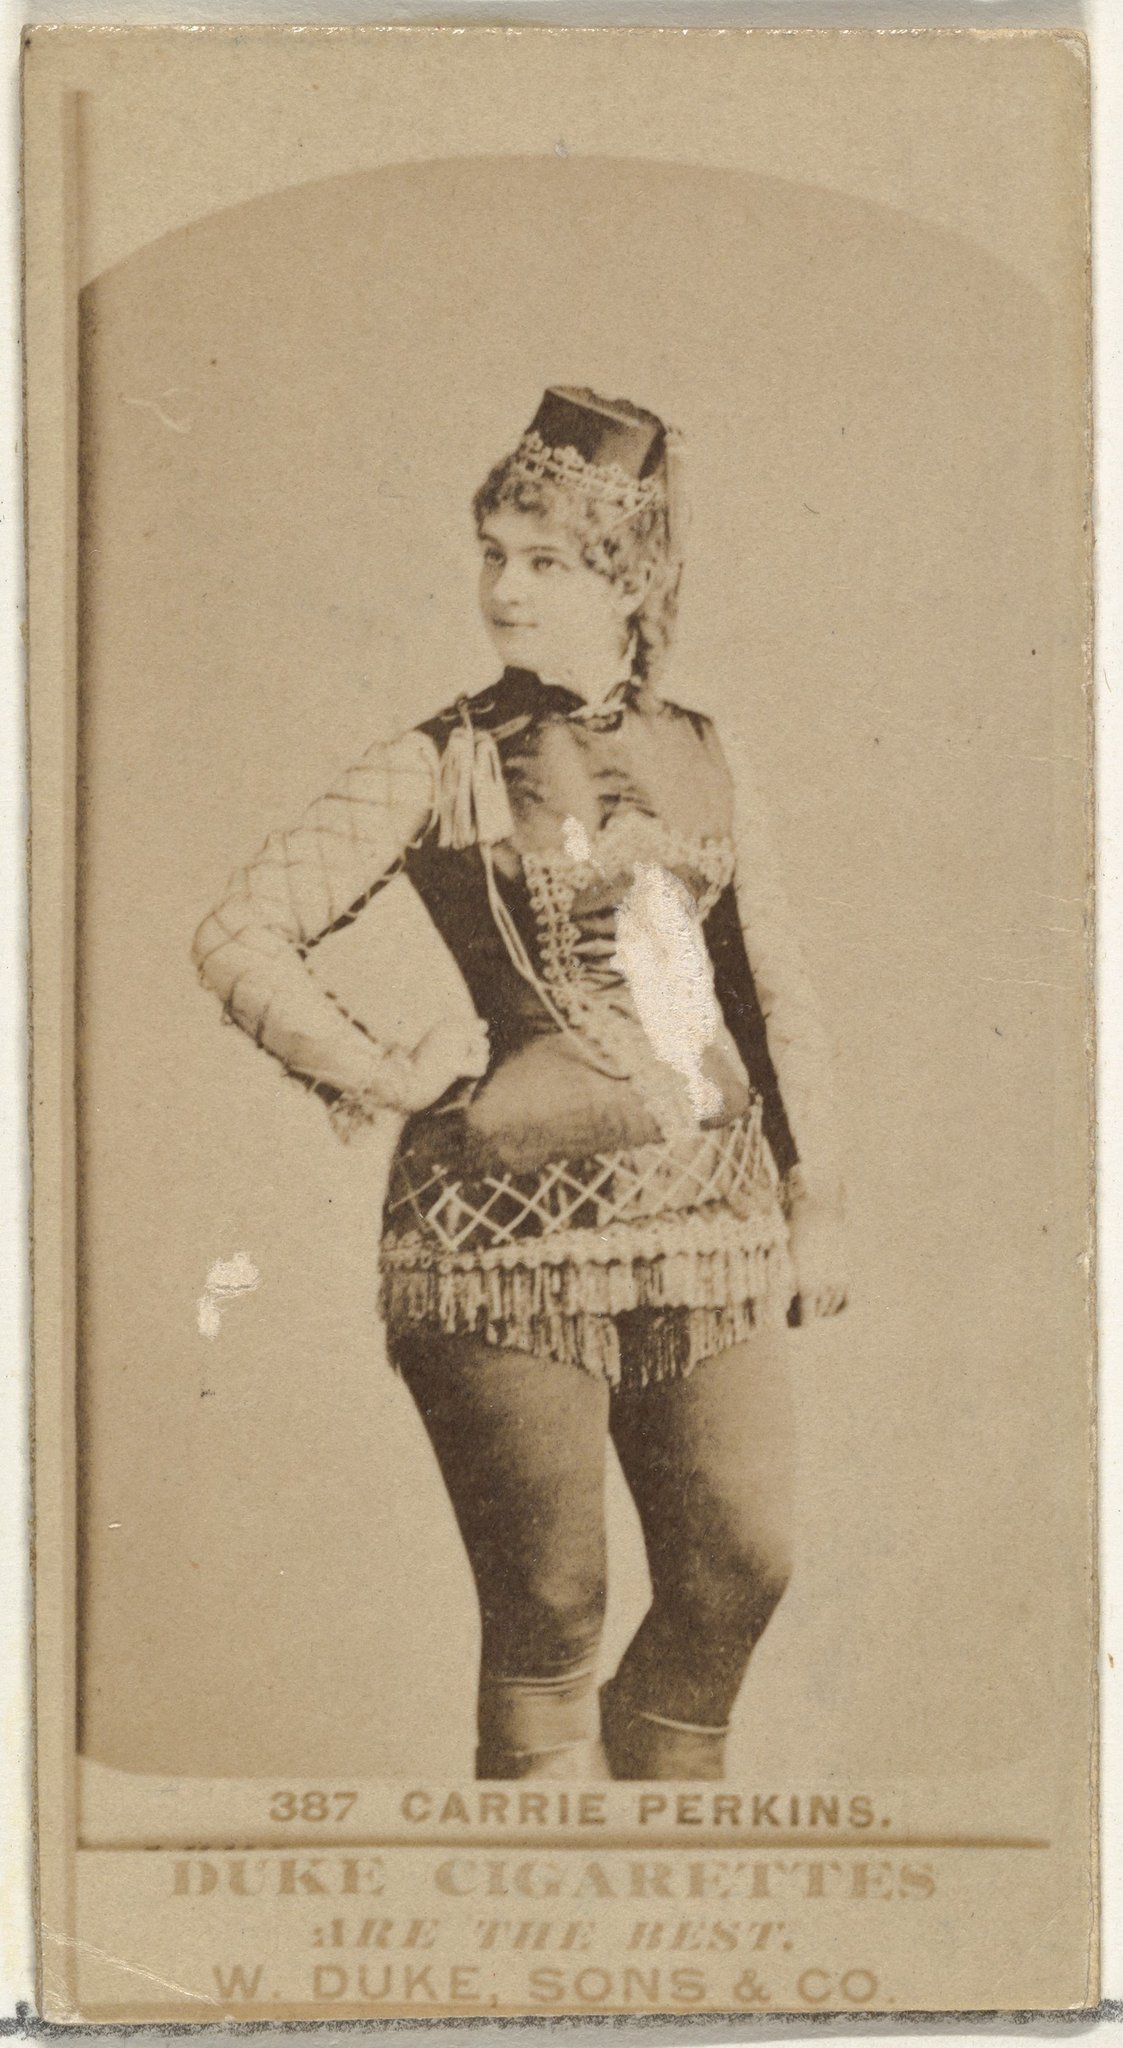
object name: photograph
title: Card Number 387, Carrie Perkins, from the Actors and Actresses series (N145-7) issued by Duke Sons & Co. to promote Duke Cigarettes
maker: w. duke, sons & co.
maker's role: publisher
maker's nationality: american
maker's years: 1870-1920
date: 1880-1889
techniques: albumen silver print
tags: portraits,women,actresses